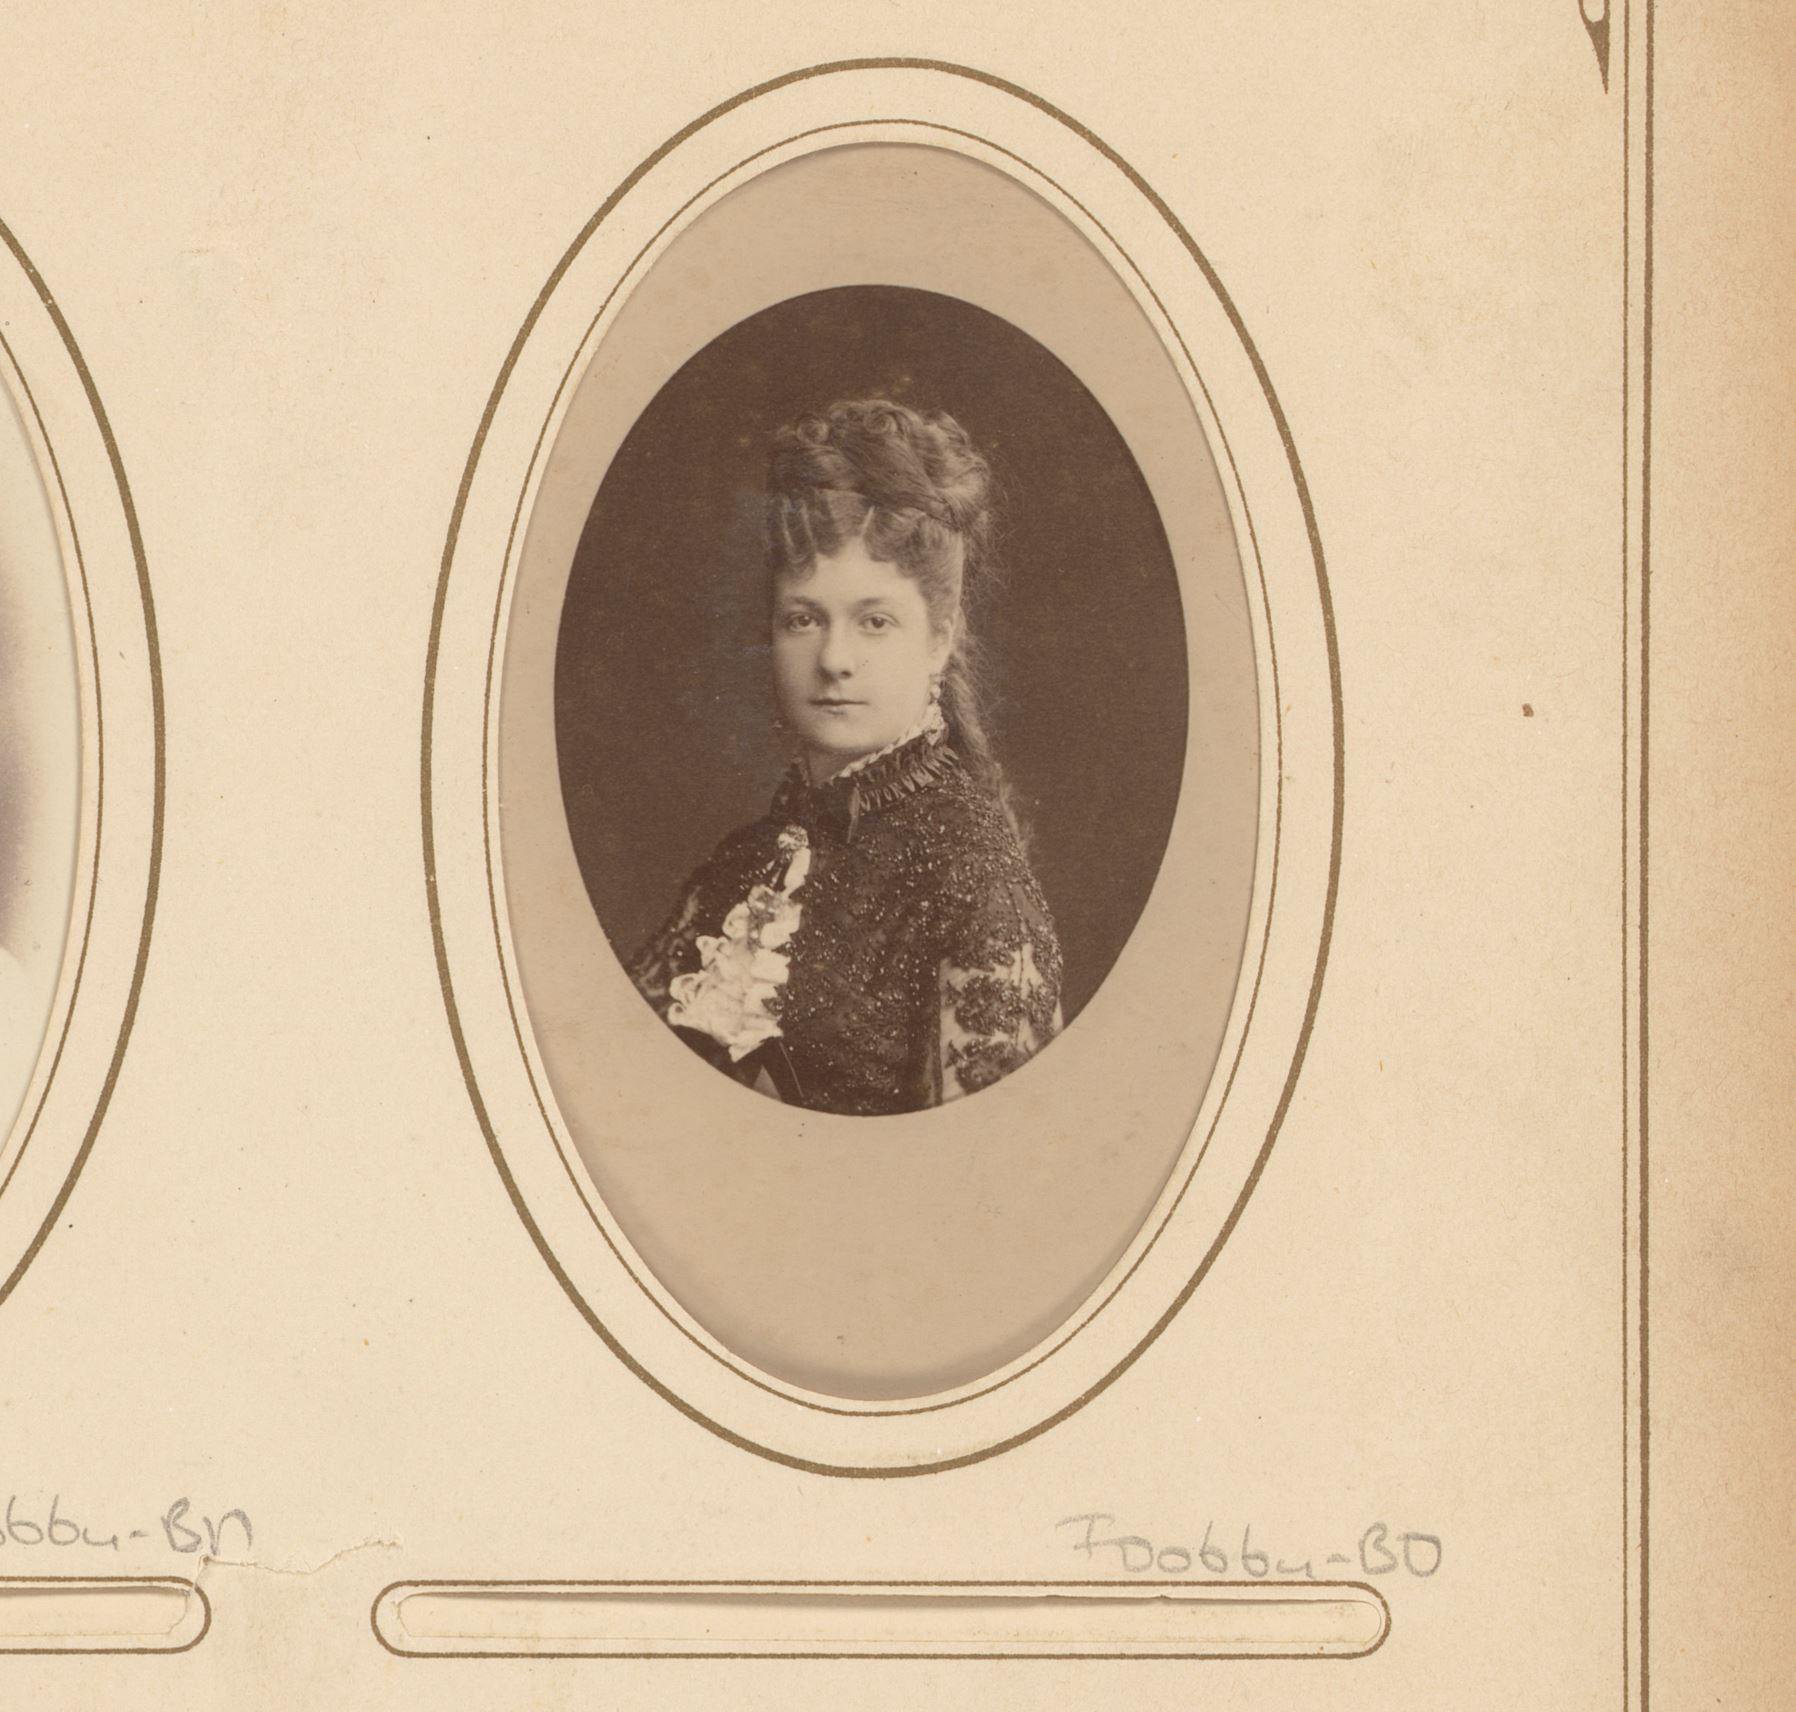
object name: semi enamel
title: Portret van een vrouw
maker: walery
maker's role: fotograaf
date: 1870-1875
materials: cardboard, celluloid, photographic support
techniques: albumen print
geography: paris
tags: historical persons - bb - woman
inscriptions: annotation: ‘Souvenir de Moedertje Gerken/ Arnhem feb 10th 1875’